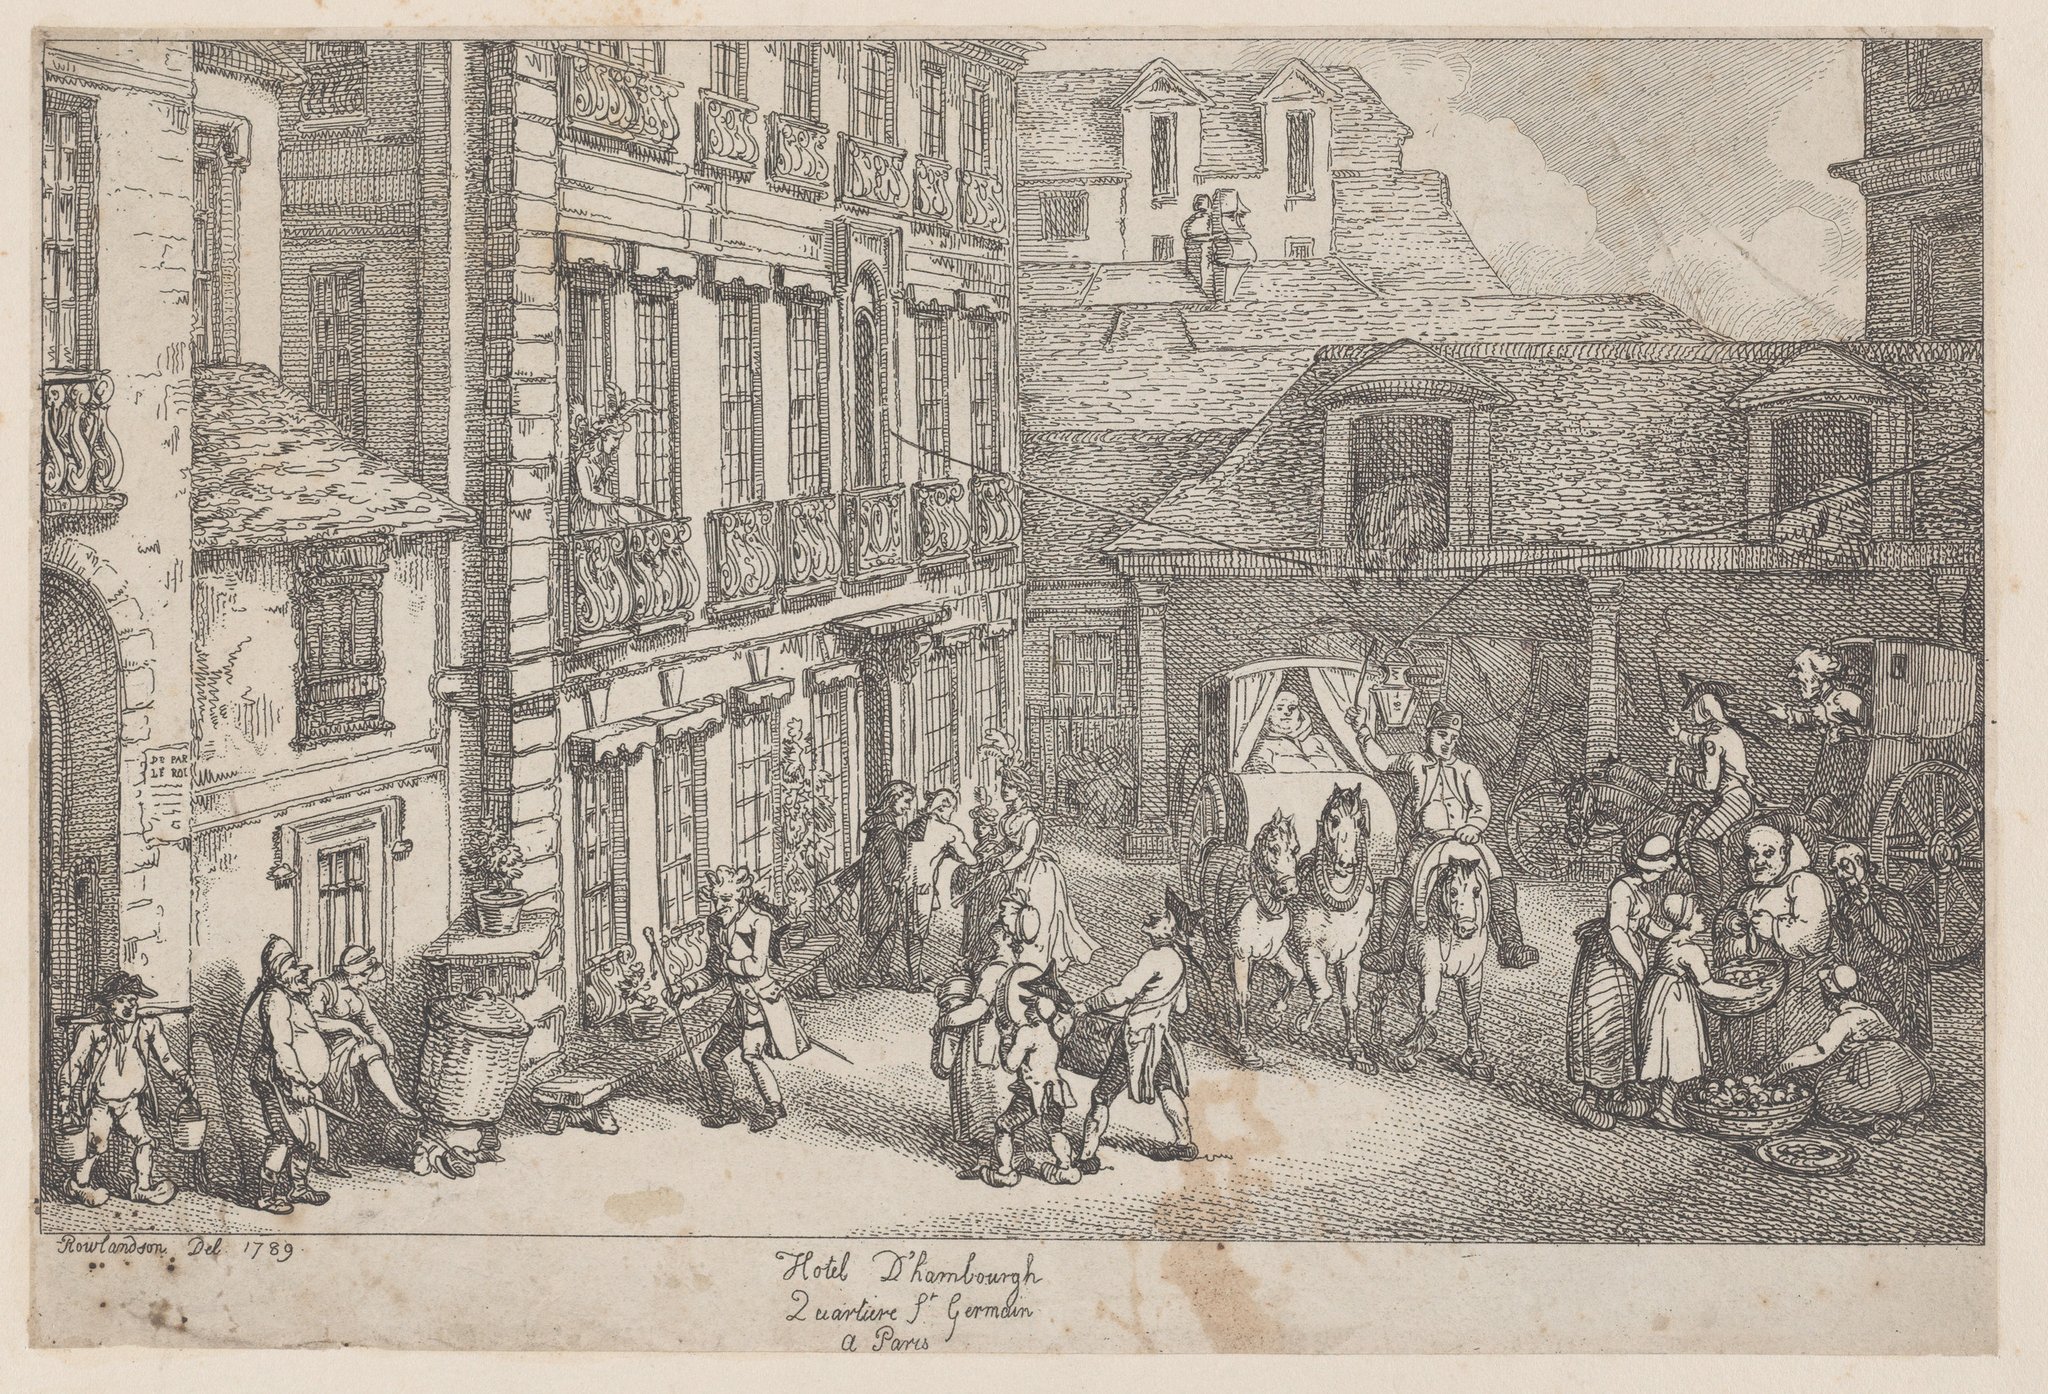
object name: print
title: Hôtel d'Hambourgh, Quartière St. Germain à Paris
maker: thomas rowlandson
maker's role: artist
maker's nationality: british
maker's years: 1757-1827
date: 1789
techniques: etching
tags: buildings,carriages,paris